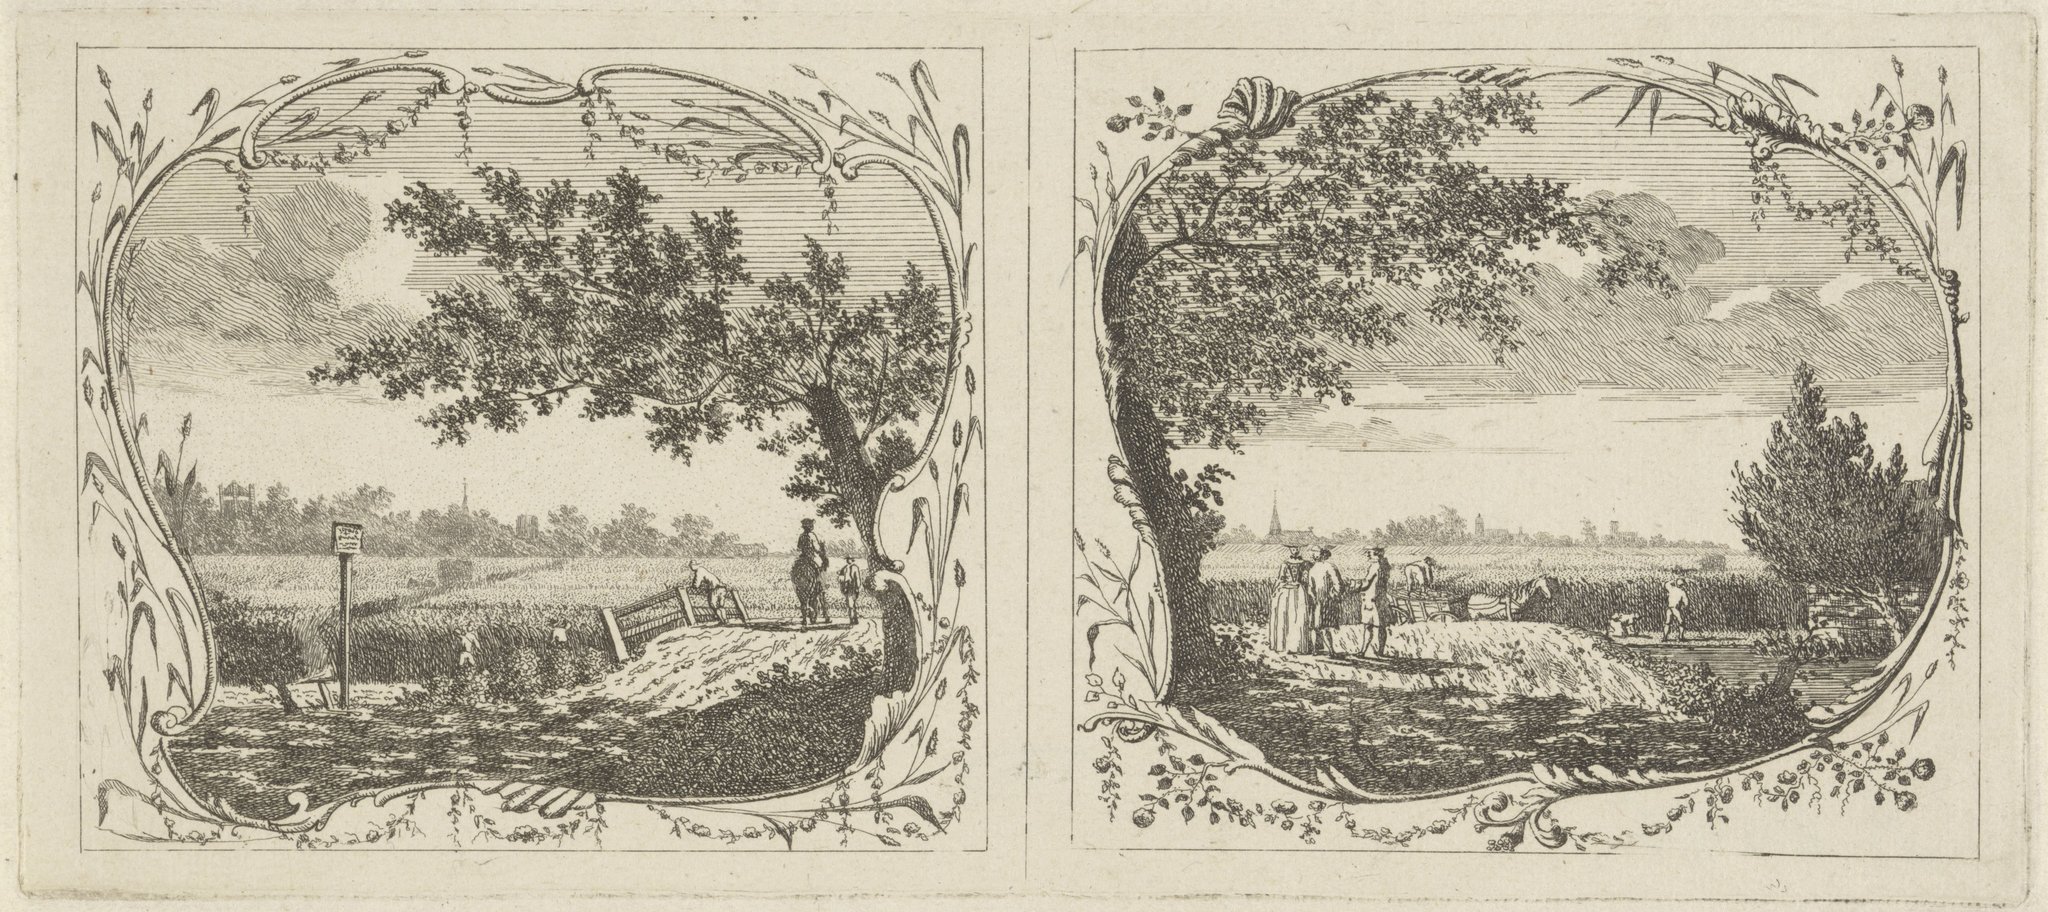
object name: print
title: Twee landschapppen in omlijstingen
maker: hendrik spilman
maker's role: draughtsman, painter, print maker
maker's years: 1721-1784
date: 1742-1784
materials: paper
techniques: etching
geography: haarlem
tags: four-wheeled vehicle drawn by one animal, landscape with bridge, viaduct or aqueduct, landscapes (+ landscape with figures, staffage), reaping, picking, mowing ~ harvest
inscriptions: collector's mark: Lugt 2228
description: Twee landschapppen in omlijstingen. Rechts een landschap met een brug, waarop een heer te paard en nog twee personen, van welke een over de leuning van de brug leunt. Links een landschap met drie converserende figuren met op de achtergrond maaiers en een paard en wagen.